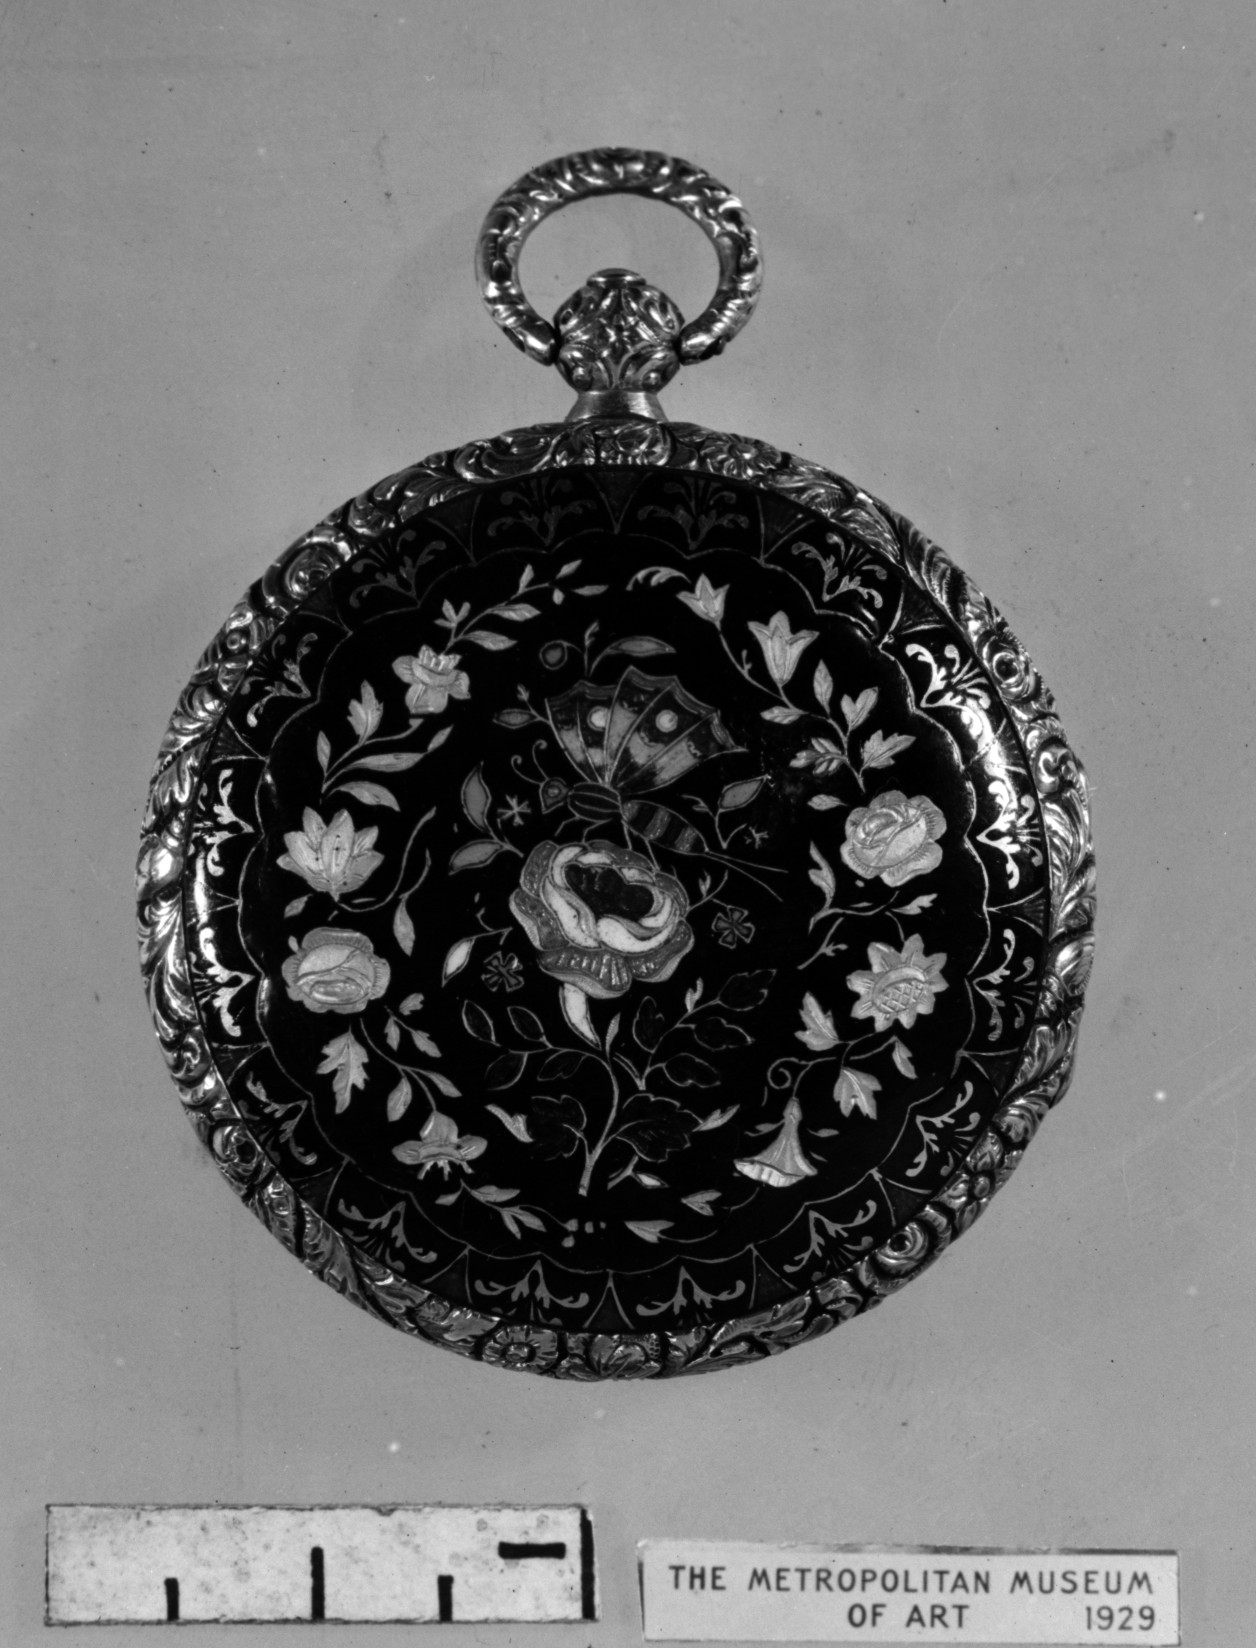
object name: watch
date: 1820-1835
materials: enamel, gold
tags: butterflies,roses,leaves